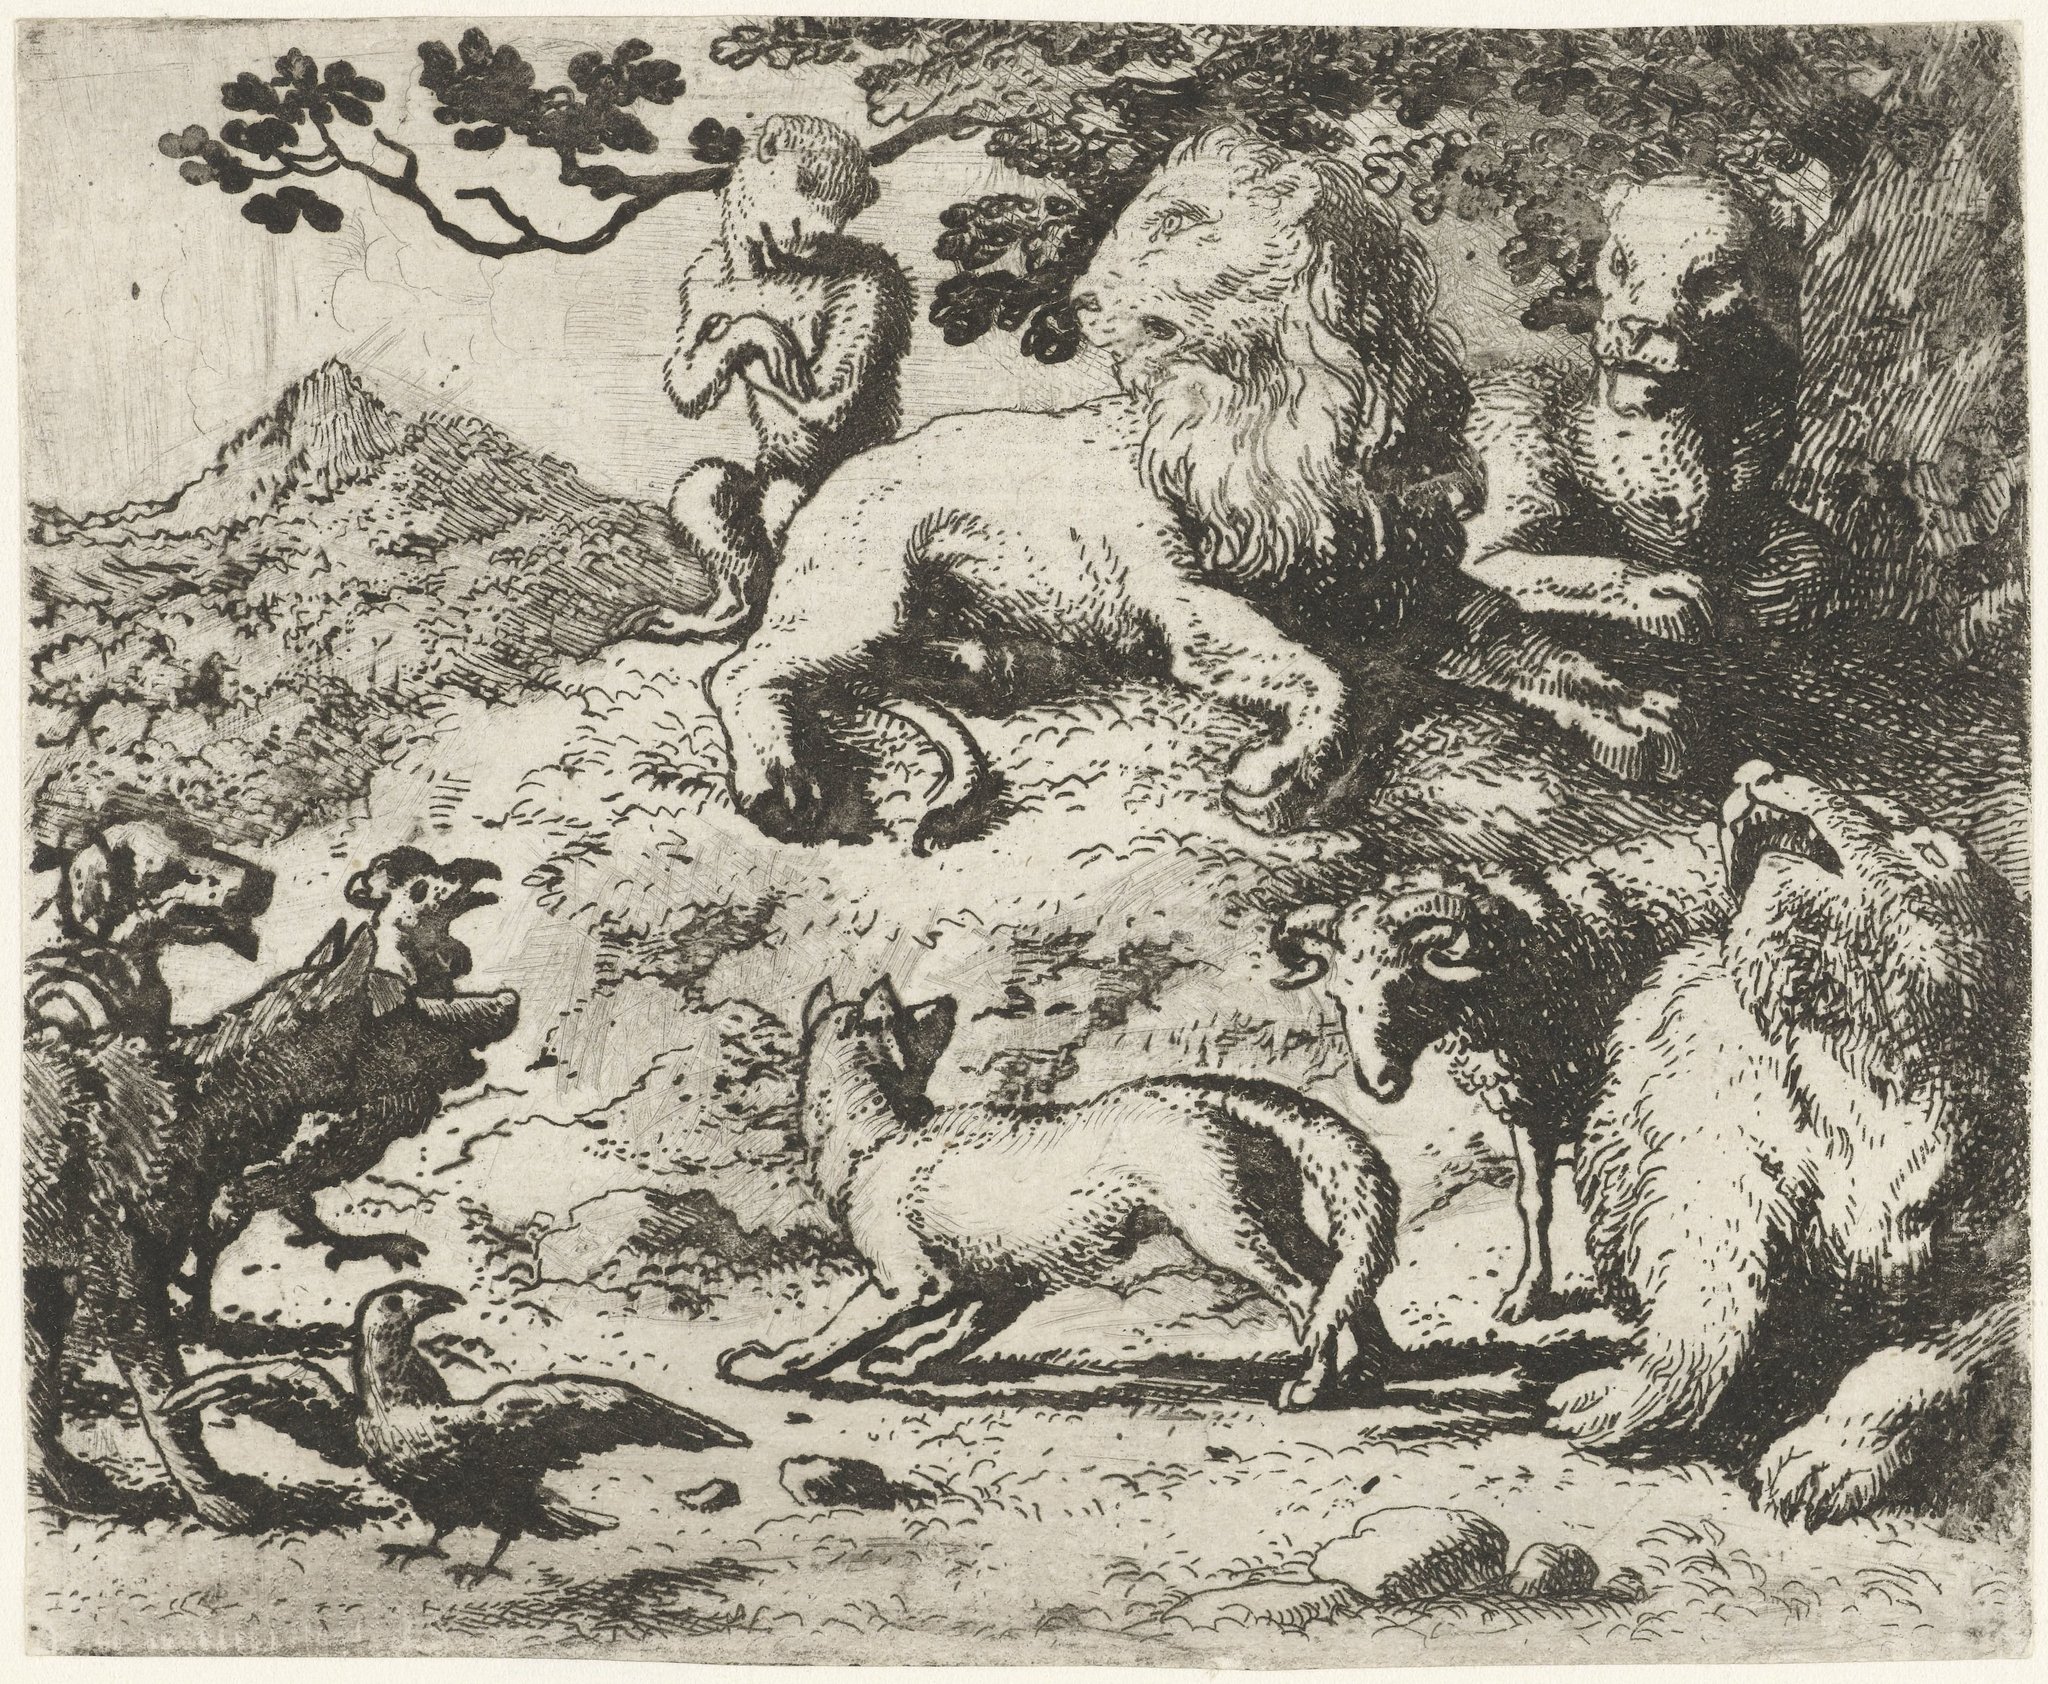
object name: print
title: Reinaert de vos' vrijspraak door de dieren aangeklaagd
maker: allaert van everdingen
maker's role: draughtsman, painter, print maker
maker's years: 1621-1675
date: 1665-1675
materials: paper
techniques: etching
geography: netherlands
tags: fable of reynard the fox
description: Reinaert de vos, met aan weerszijden de andere dieren, kijkt omhoog naar de heuvel waar koning Nobel de leeuw, de koningin en Botsaert de aap zitten.